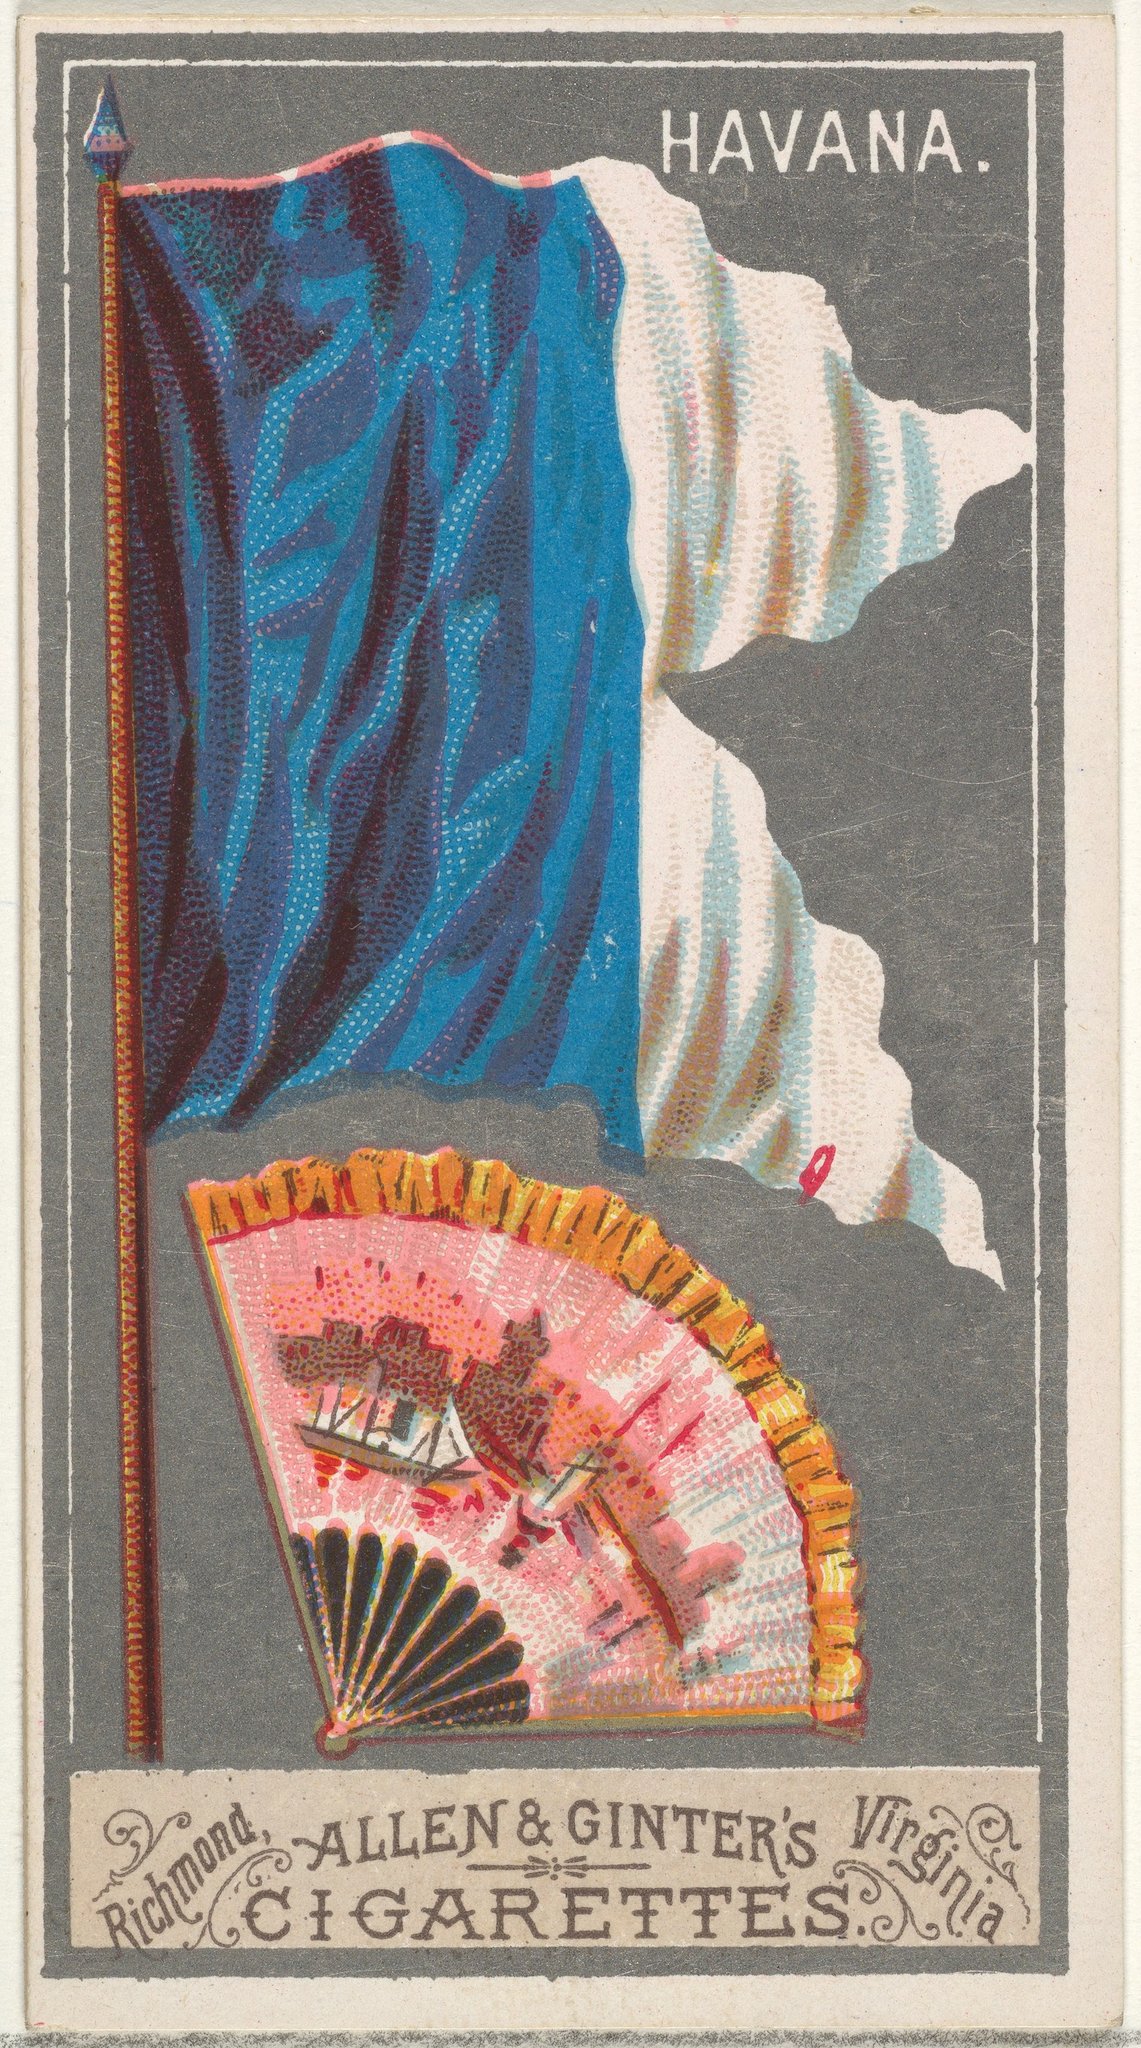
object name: print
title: Havana, from the City Flags series (N6) for Allen & Ginter Cigarettes Brands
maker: allen & ginter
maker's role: publisher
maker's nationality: american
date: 1887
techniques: color lithograph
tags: fans,flags